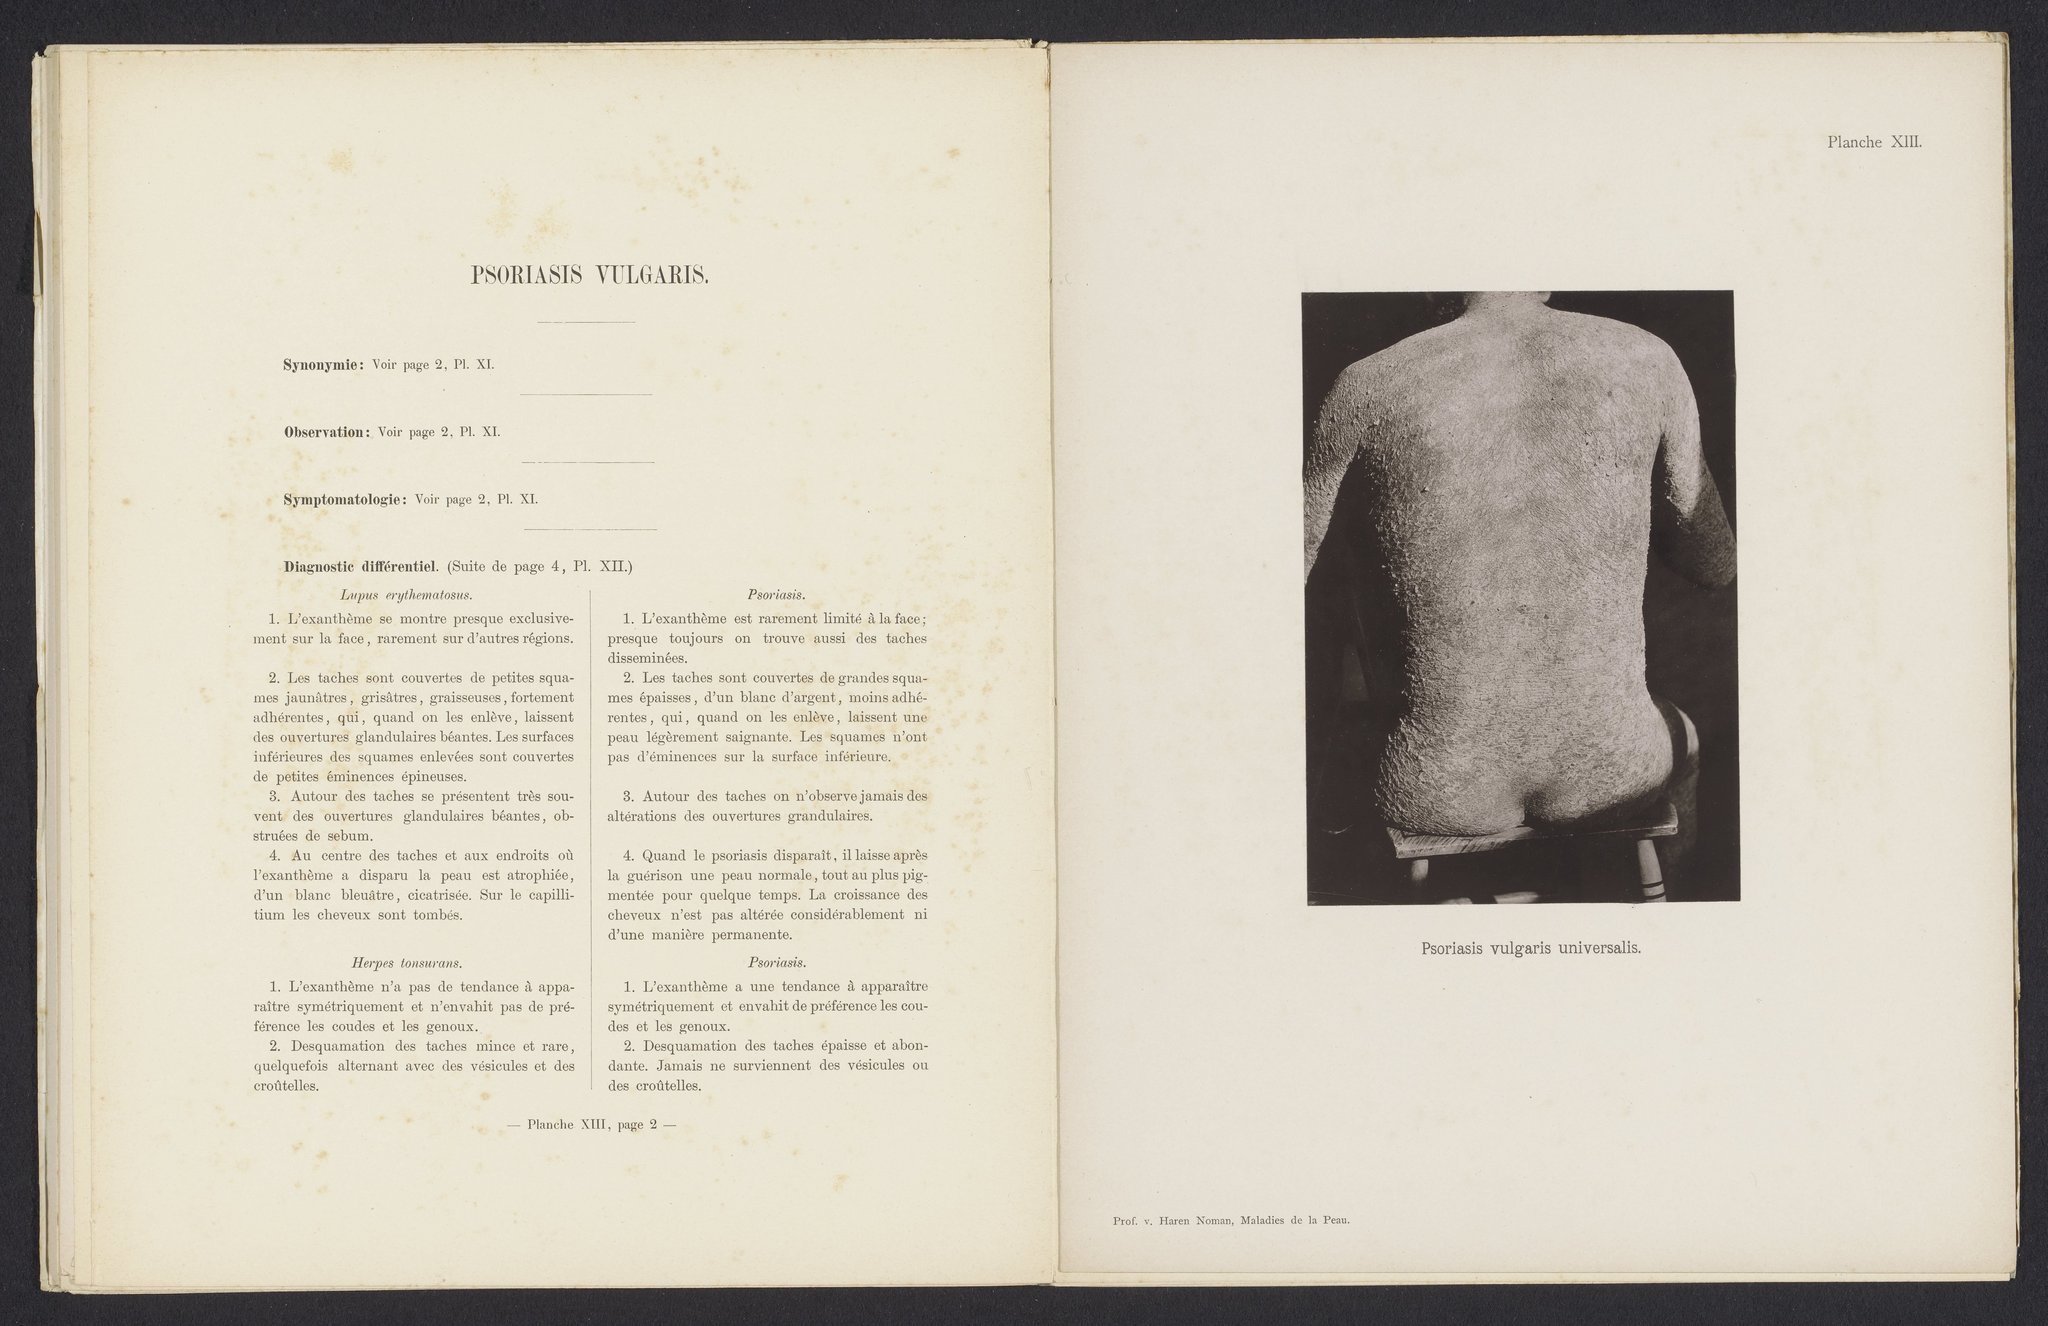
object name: page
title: Patiënt lijdend aan de huidziekte 'psoriasis vulgaris universalis'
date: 1880-1889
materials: paper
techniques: photograph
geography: amsterdam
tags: skin and venereal diseases, back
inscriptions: number: ‘Planche XIII.’